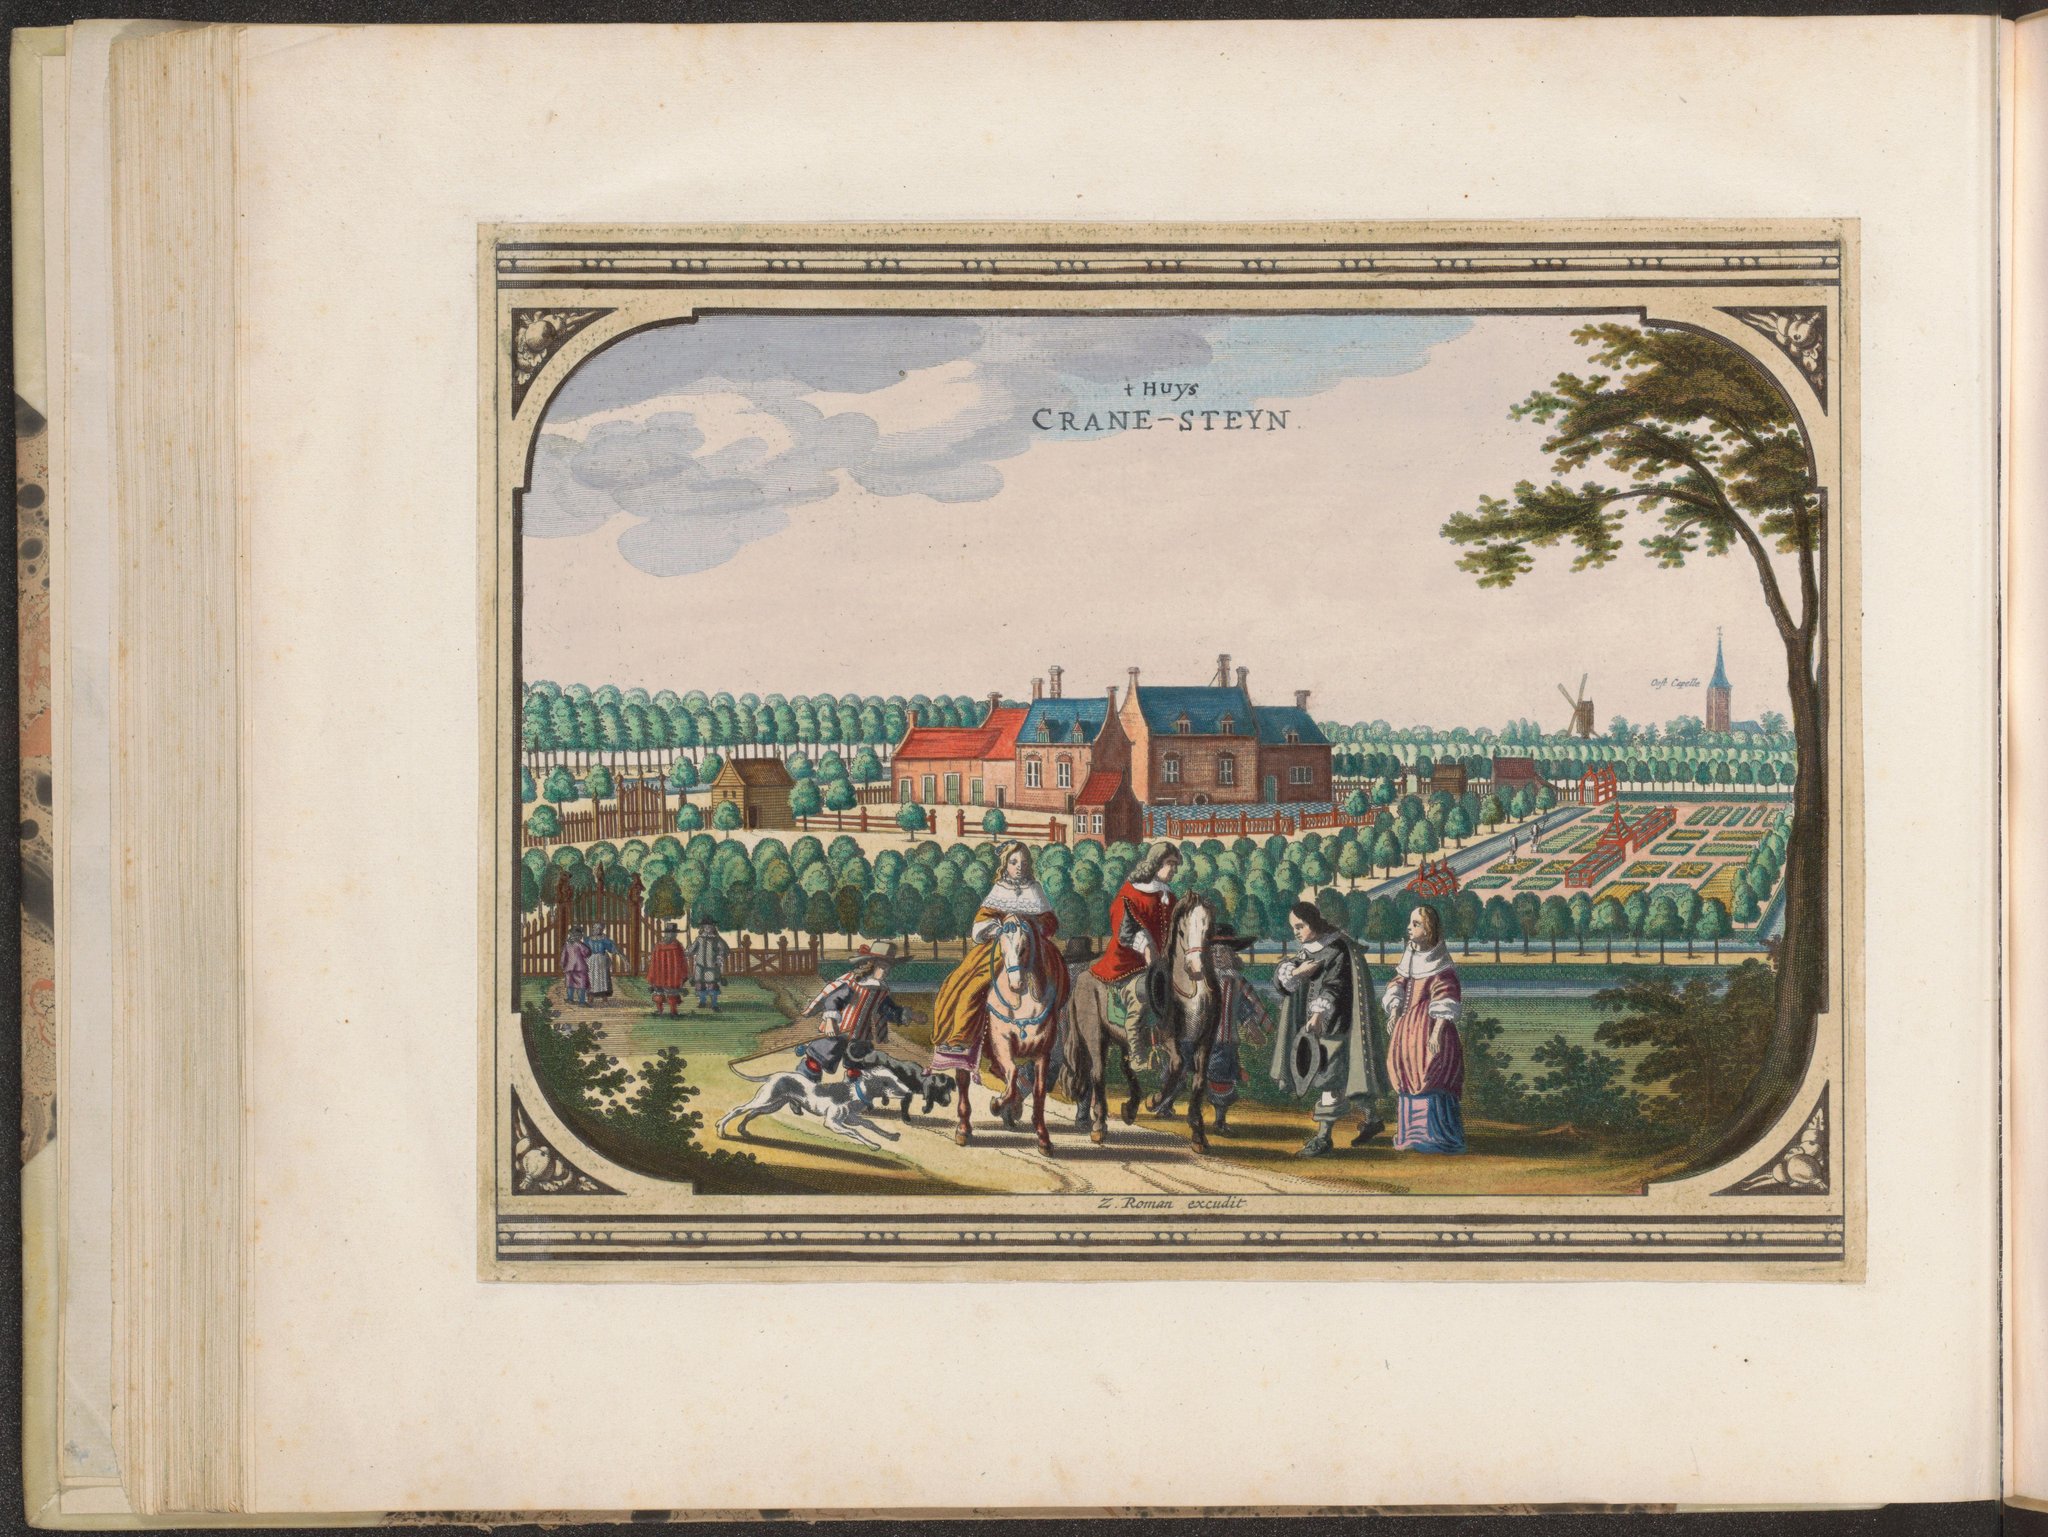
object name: print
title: Gezicht op Huis Cranesteyn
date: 1662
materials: paper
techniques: etching, hand coloring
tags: riding a horse, ass, or mule; rider, horseman, city-view, and landscape with man-made constructions, baring the head, lifting one's hat, the rich, country-house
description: Gezicht op Huis Cranesteyn, een hofstede net ten zuidoosten van de dorpskern van Oostkapelle. Op de voorgrond worden een man en vrouw te paard begroet door een welgesteld paar. De man neemt zijn hoed af. De prent maakt deel uit van een album.